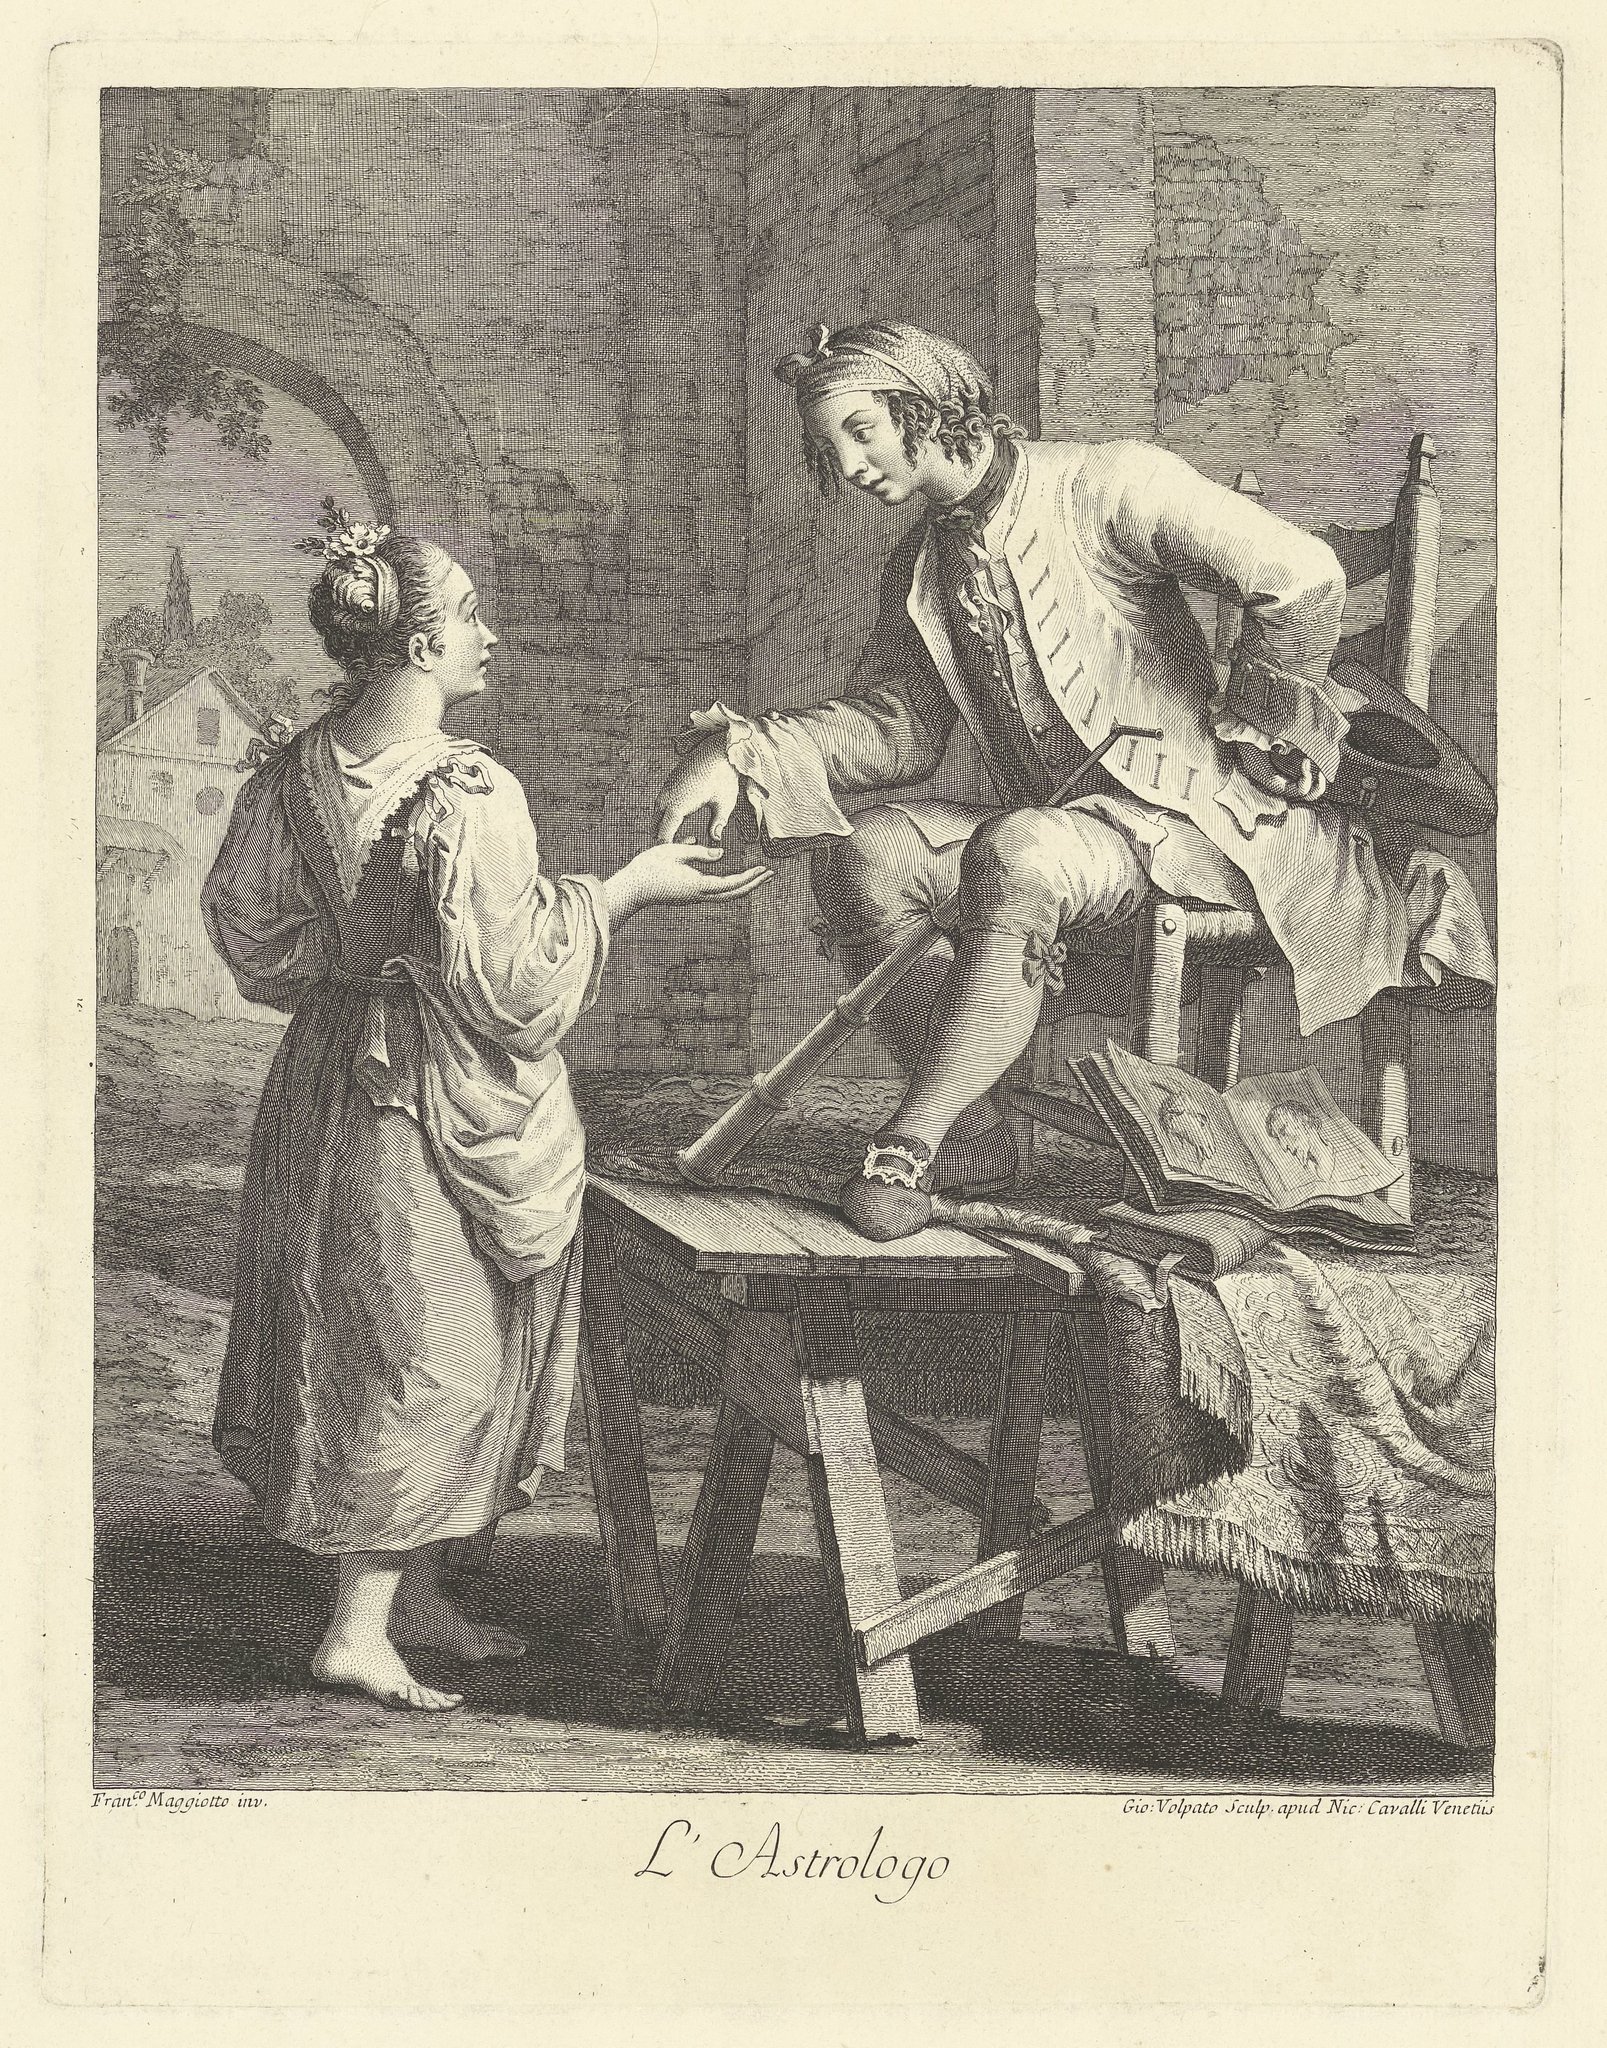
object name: print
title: L'astrologo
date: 1743-1803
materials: paper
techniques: engraving, etching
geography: venice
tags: astrologer at work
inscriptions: collector's mark: Lugt 2228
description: Een astroloog zittend op een verhoging. Voor hem een vrouw die hem wil betalen.